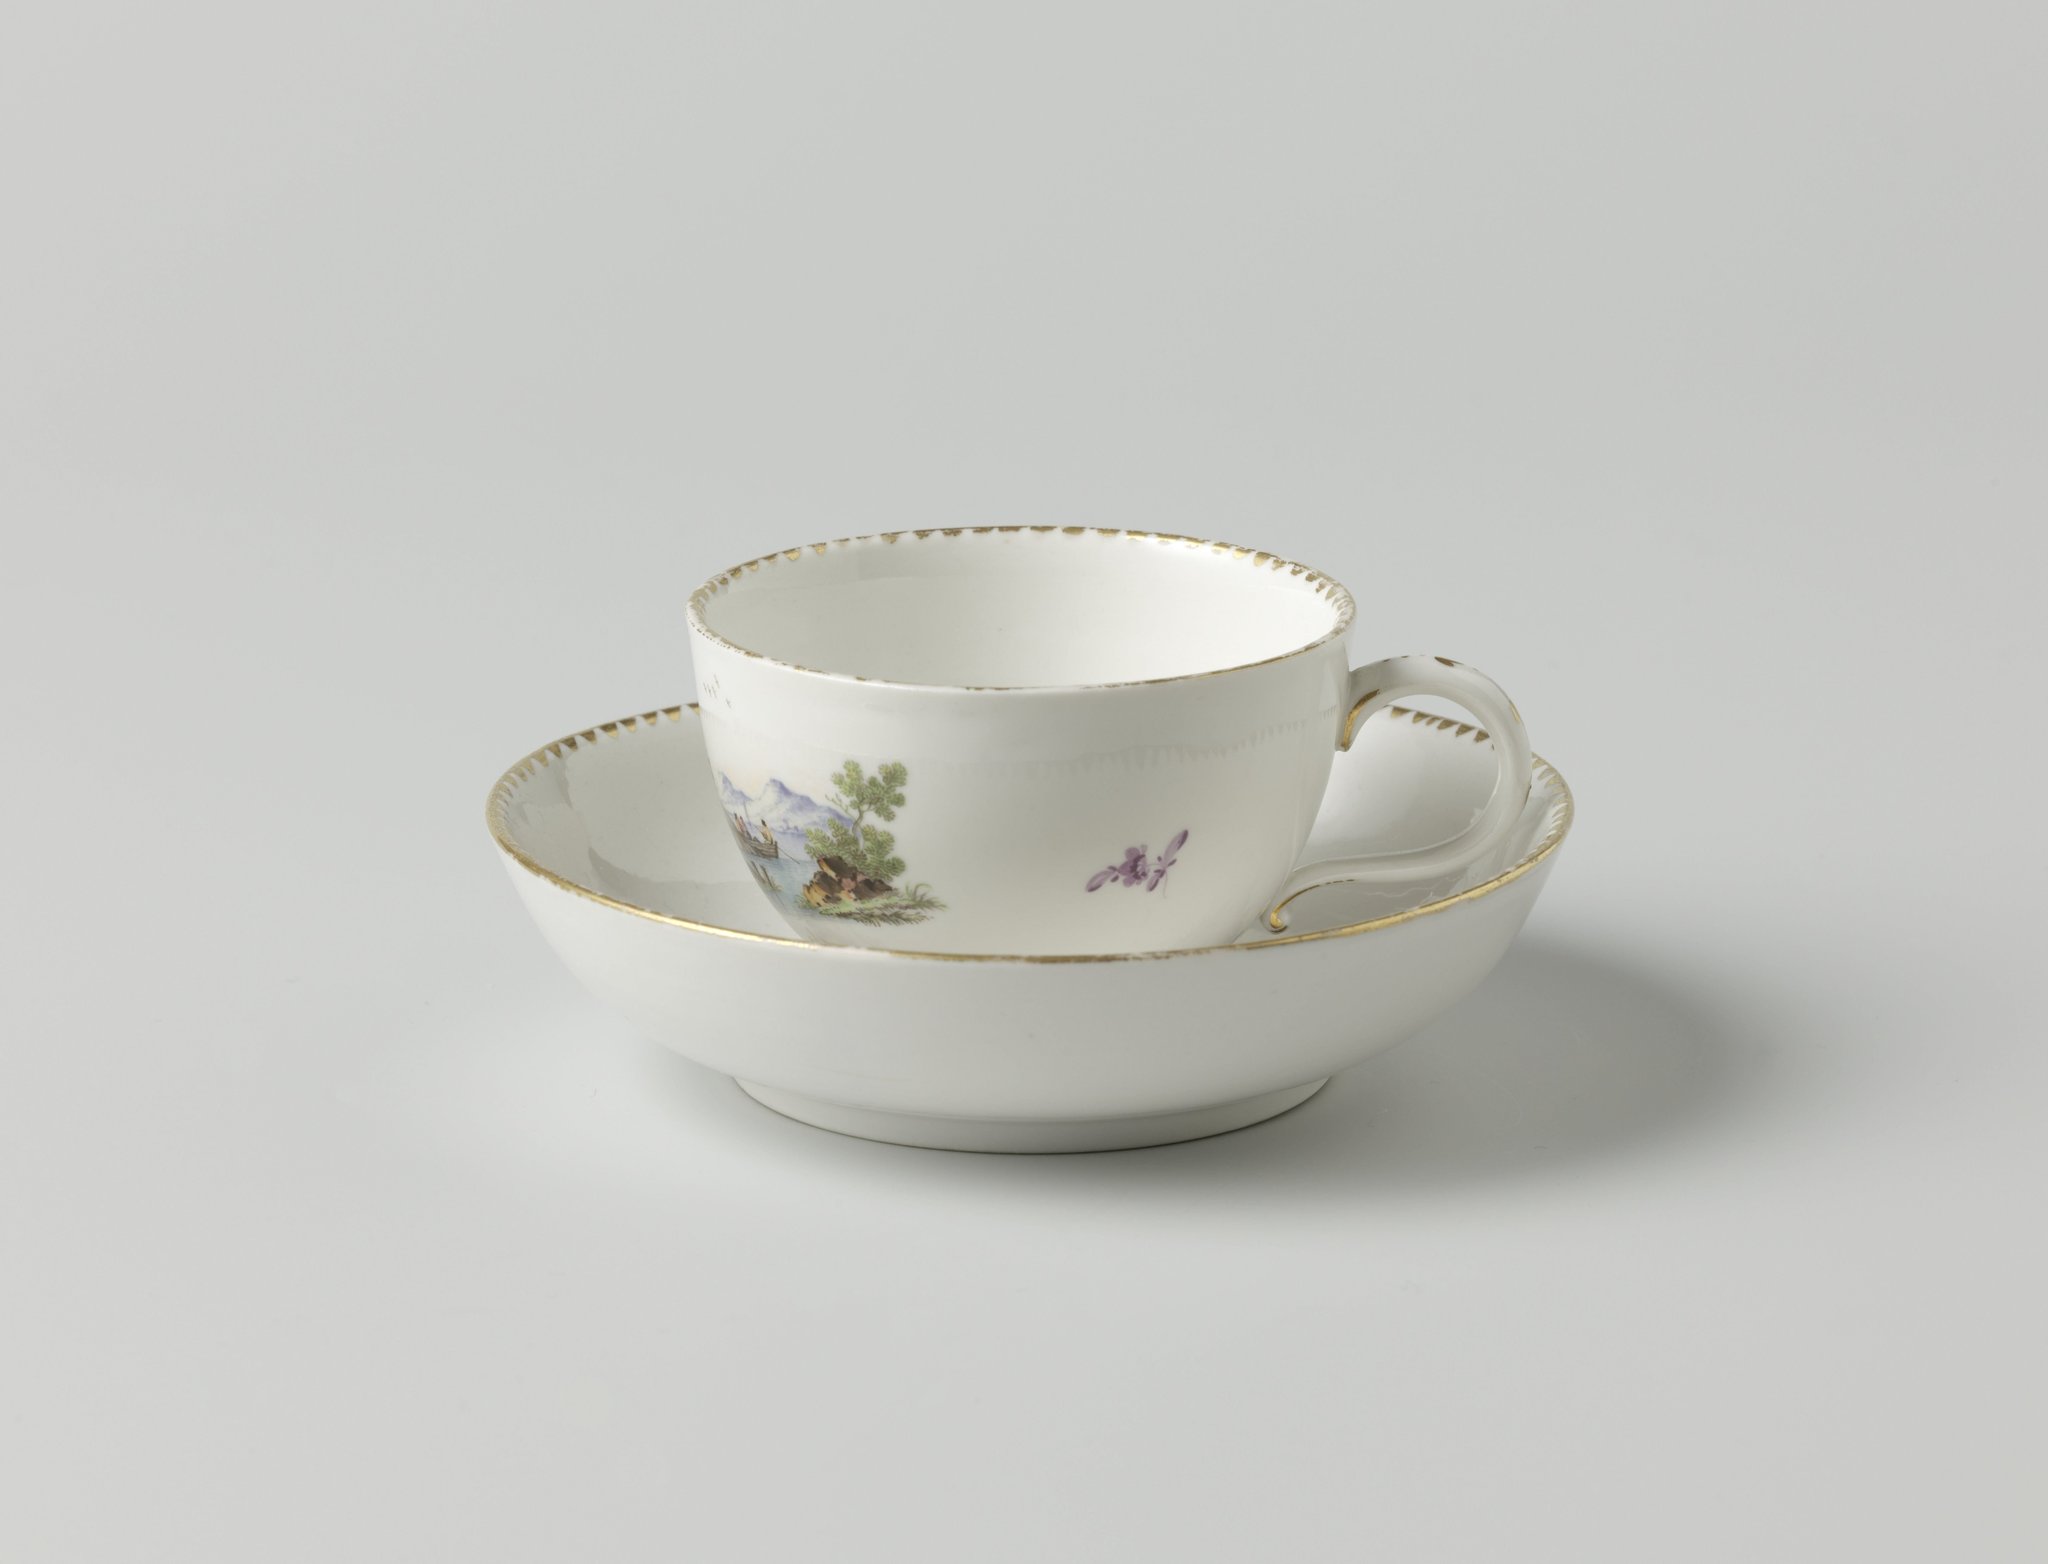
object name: kop en schotel, kop en schotel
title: Kop en schotel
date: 1777-1790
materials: porcelain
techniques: painted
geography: the hague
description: Tea cup and saucer. Porcelain. Ansbach, decorated in The Hague, c. 1777 - 1790. Factory of Anton Lyncker or his heirs.